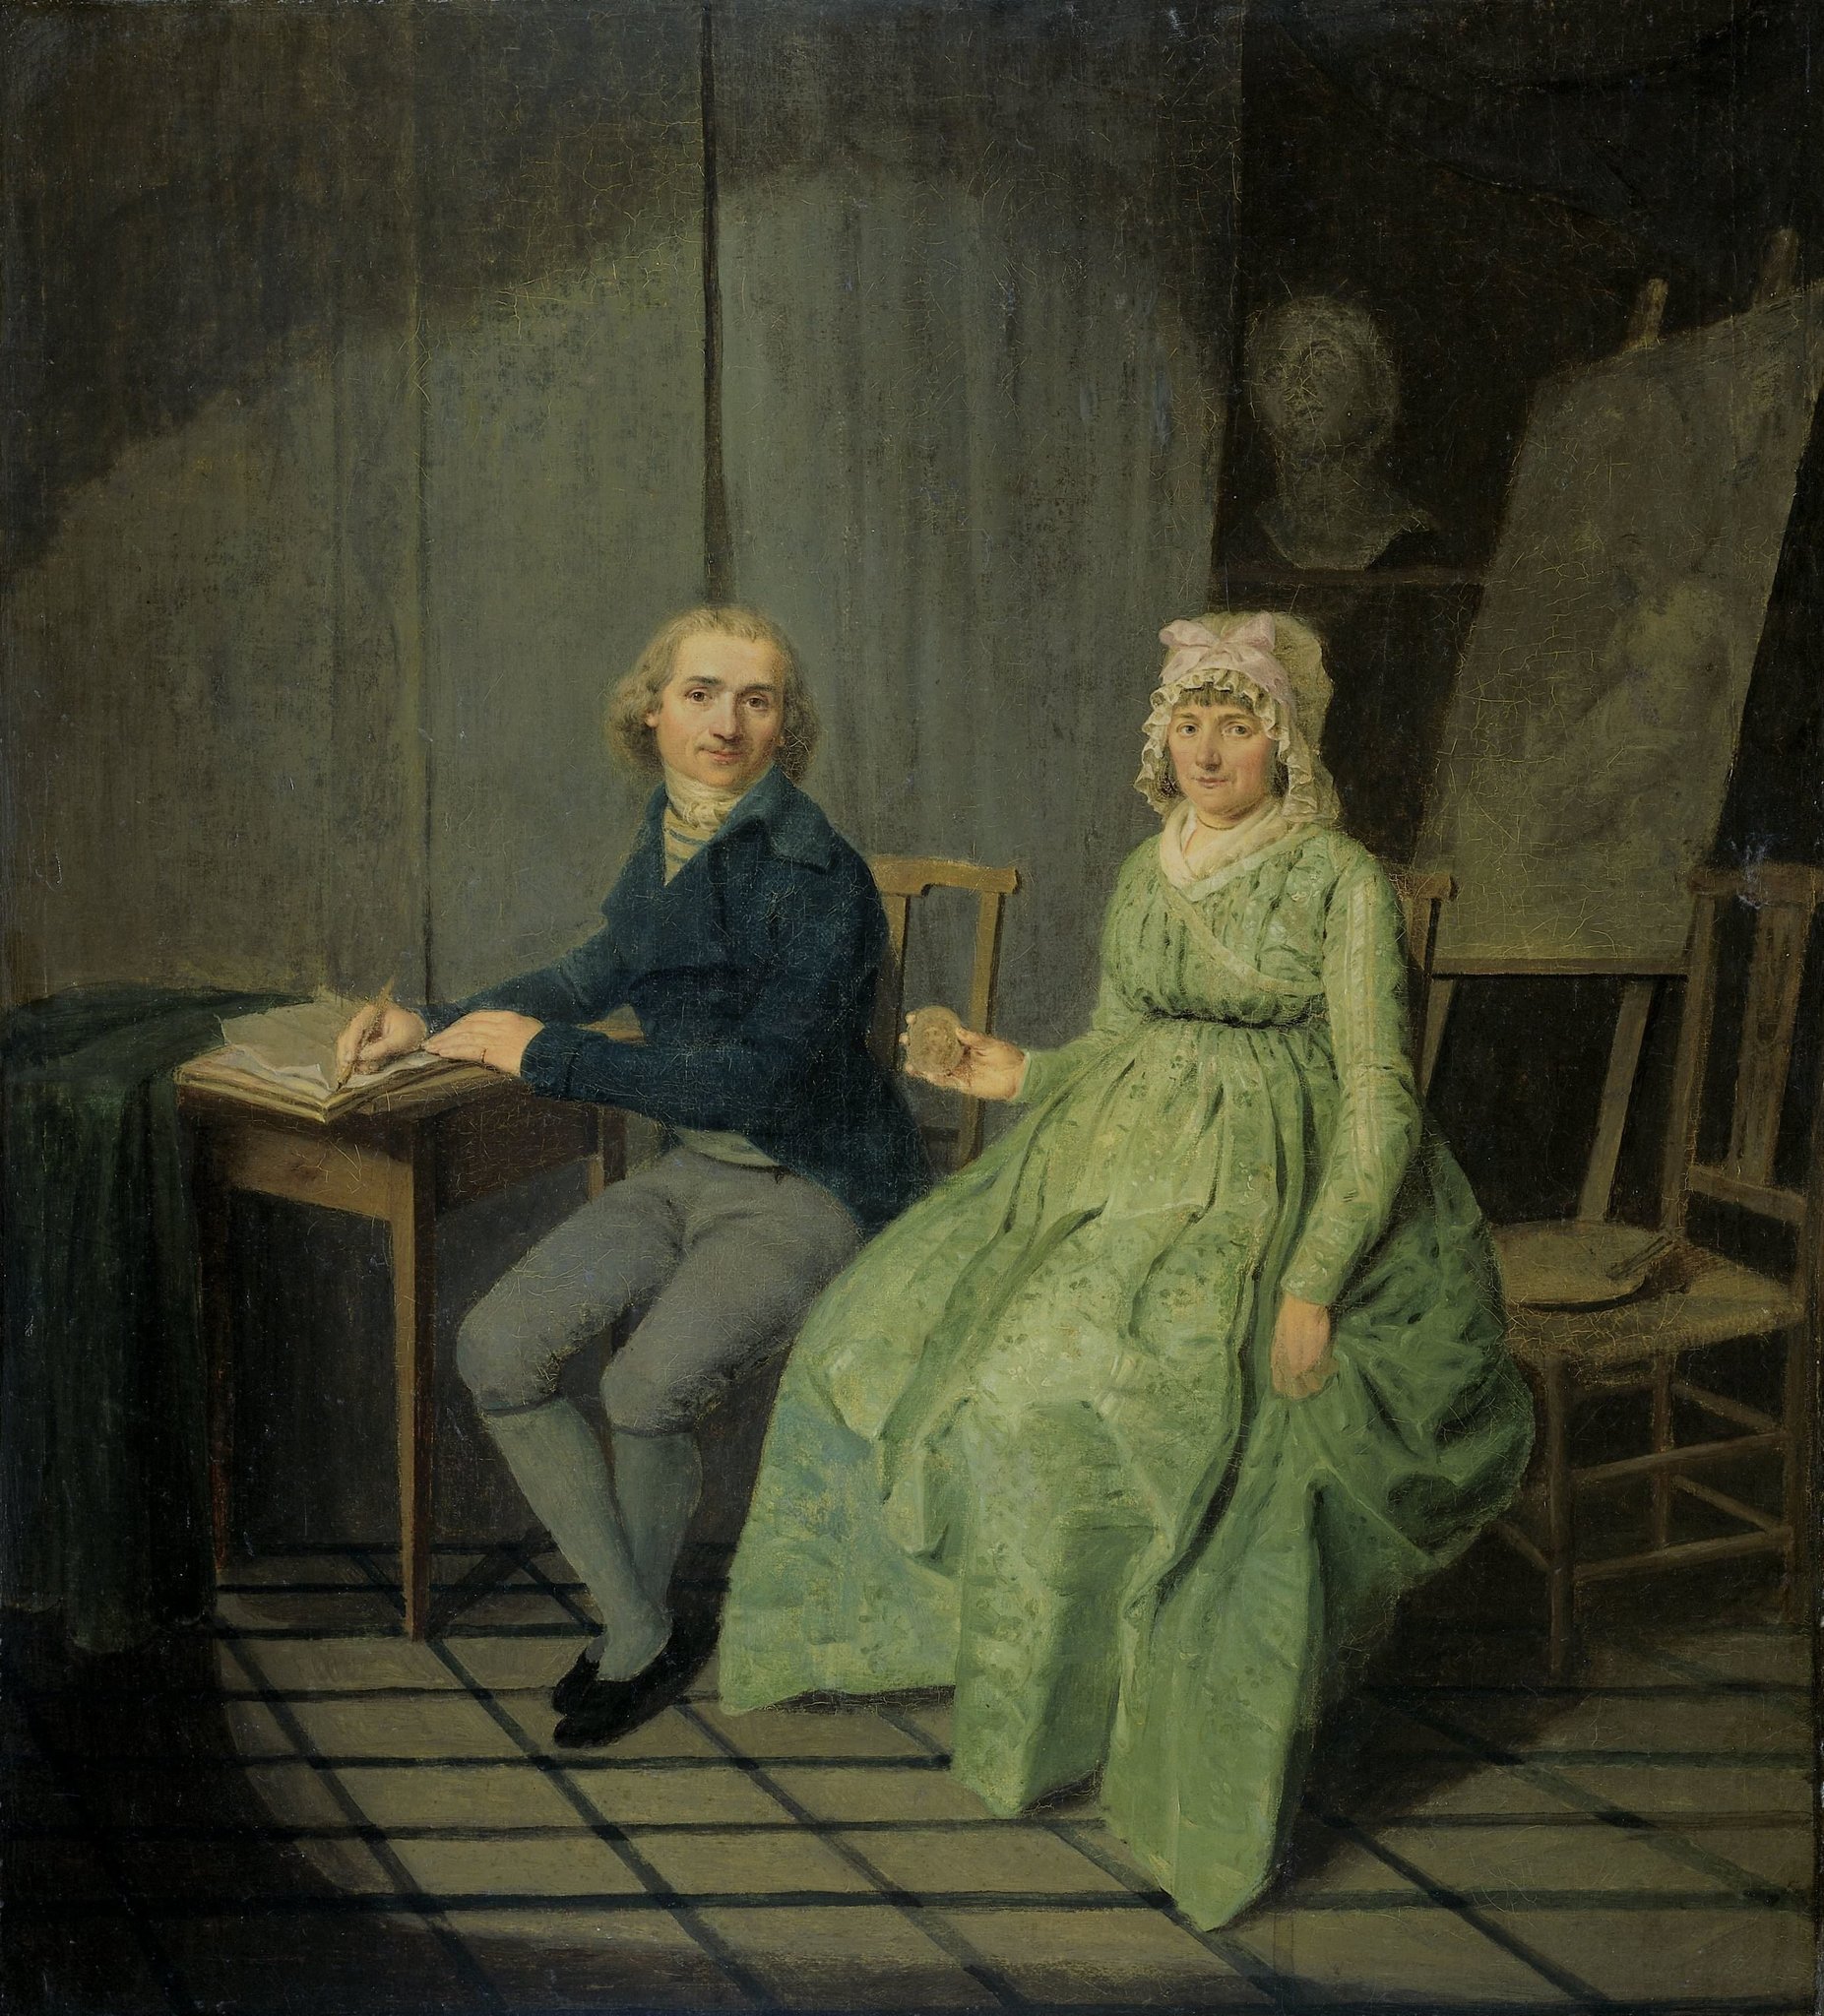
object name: painting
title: A Painter with his Wife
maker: wybrand hendriks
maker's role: draughtsman, painter, print maker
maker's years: 1744-1831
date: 1791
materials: canvas, oil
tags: amsterdam, haarlem, print maker, draughtsman, wybrand hendriks, historical persons - bb - woman, historical persons, portrait, self-portrait of painter, portrait, self-portrait of artist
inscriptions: signature and date: ‘W. Hendriks 1791’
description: Dubbelportret van de schilder Wybrand Hendriks met eerste echtgenote Agatha Ketel. Zittend in een interieur, de man schrijvend aan een tafeltje, de vrouw houdt een portretmedaillon omhoog. Op de achtergrond een schildersezel en een gipsen kop.